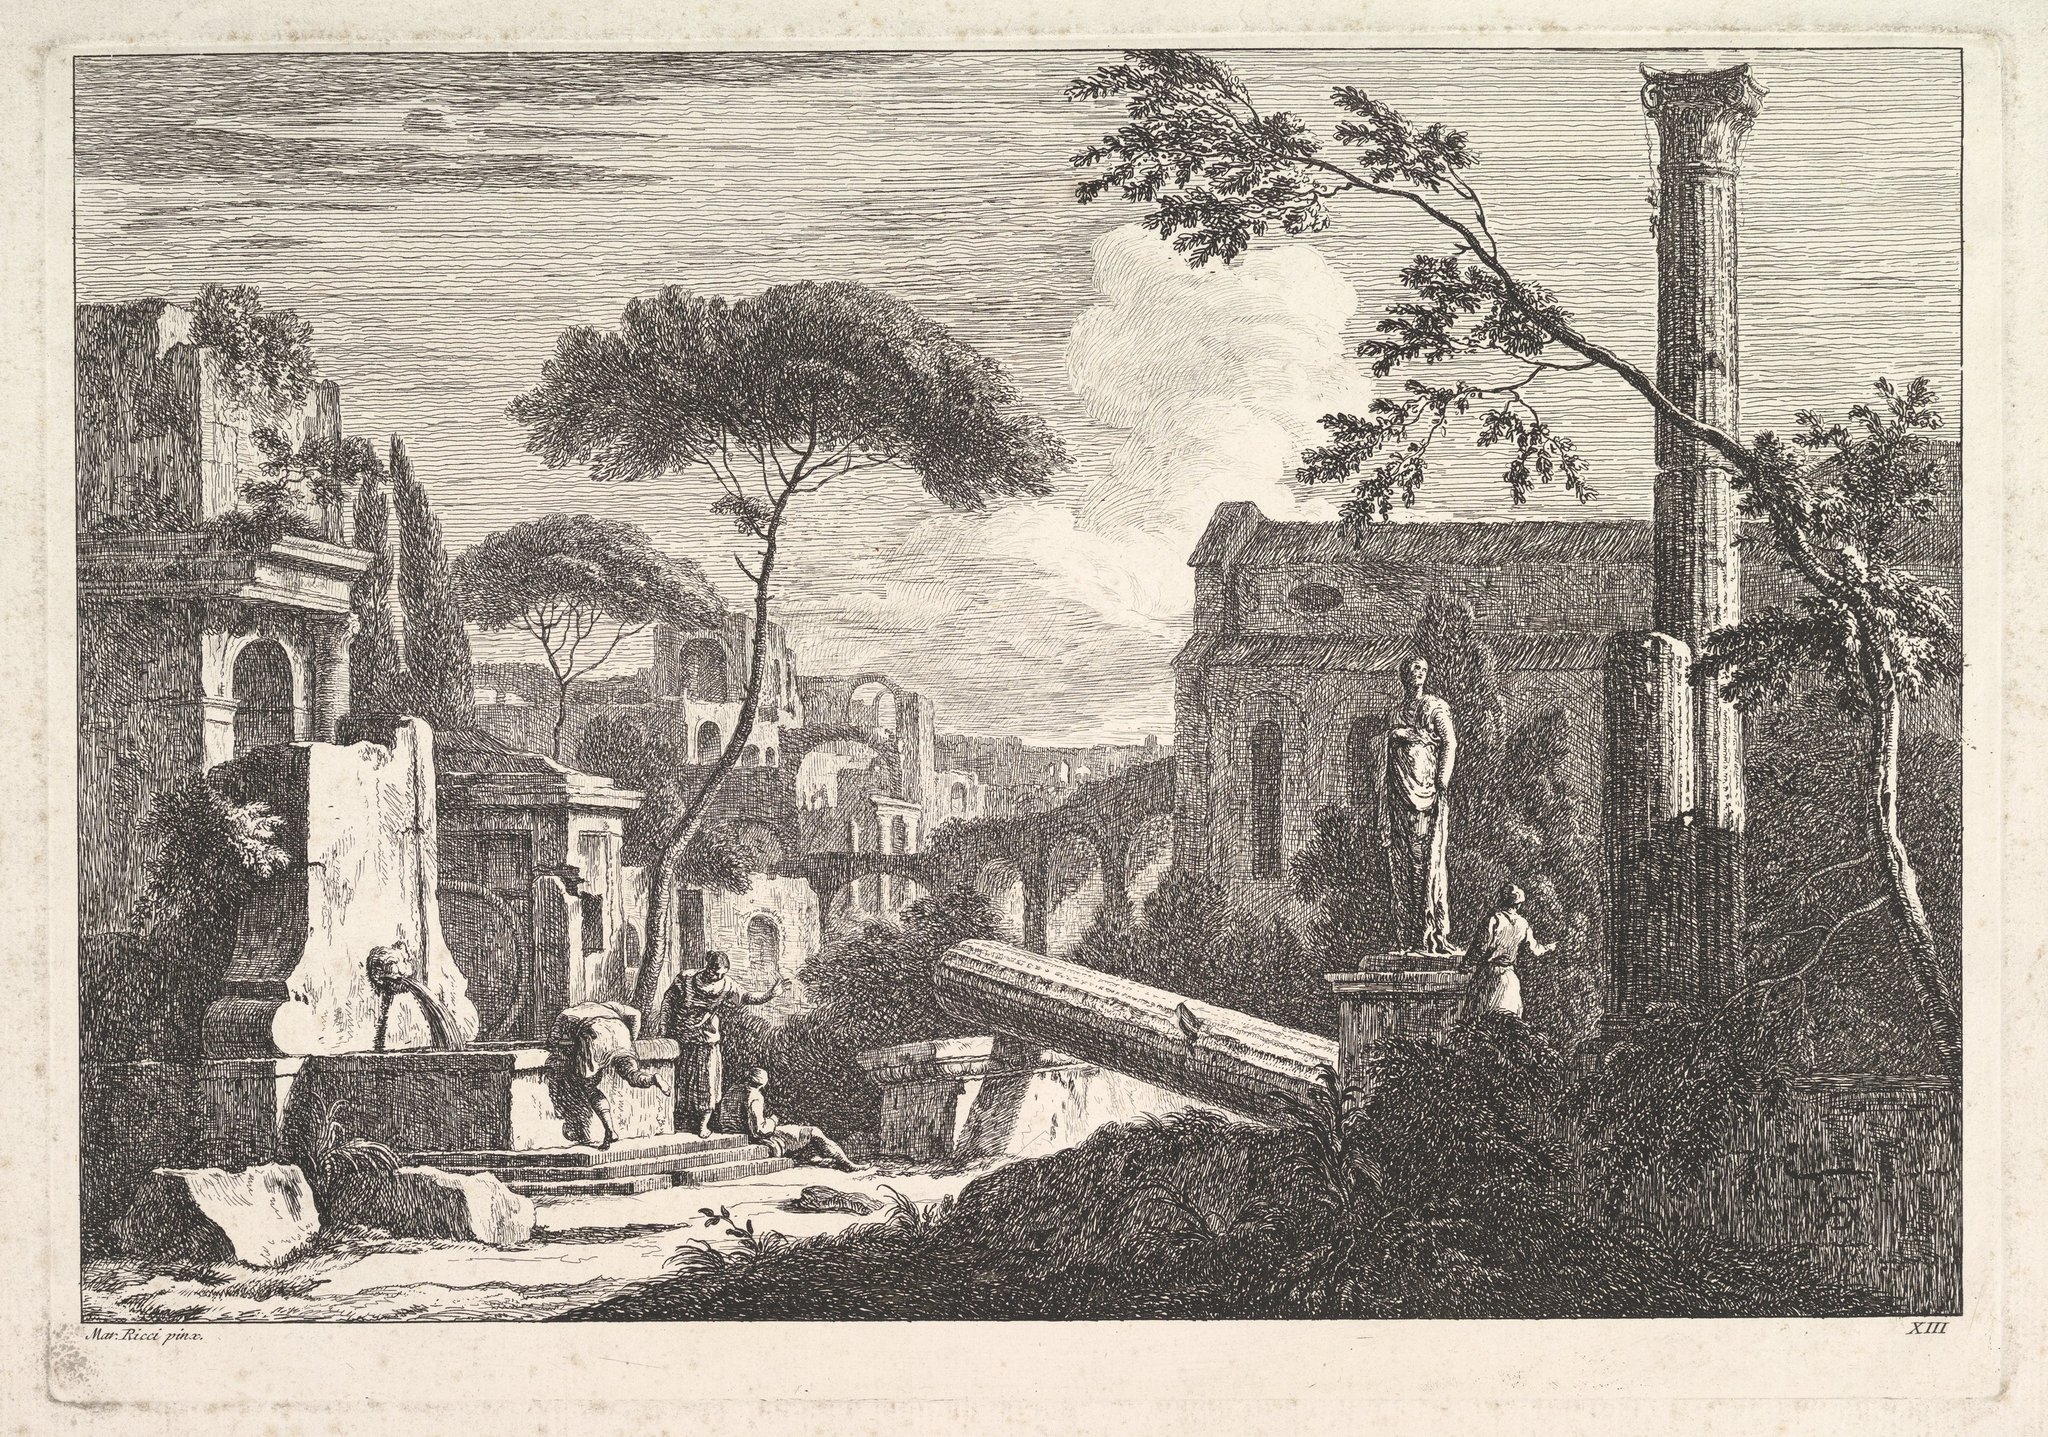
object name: print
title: Plate 13: a townscape with a fountain, fallen column and statue at right and a Gothic church beside an aqueduct in the background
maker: davide antonio fossati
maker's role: artist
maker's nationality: italian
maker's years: 1708-1791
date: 1743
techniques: etching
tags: ruins,landscapes